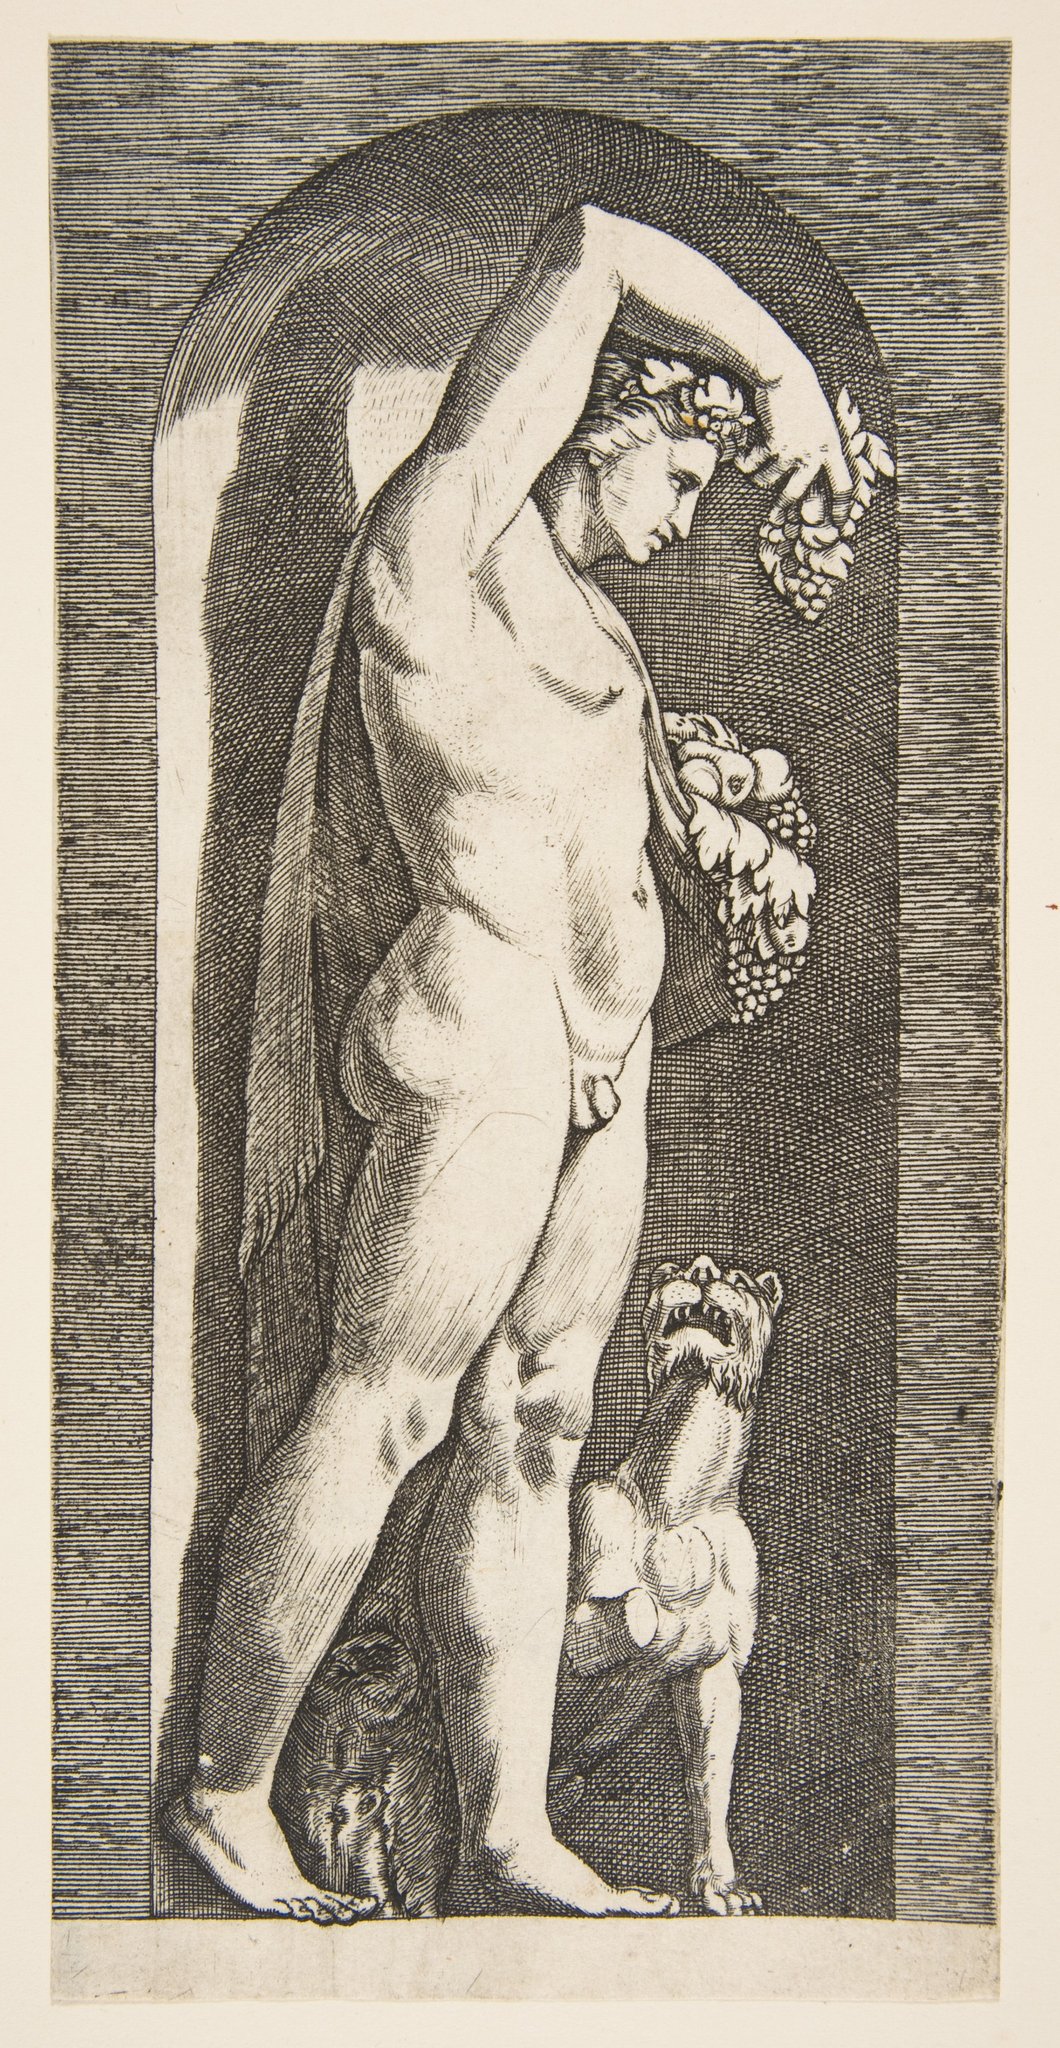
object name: print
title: Bacchus standing in a niche holding grapes in his raised right hand, fruit in his left hand, a dog lower right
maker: marco dente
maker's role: artist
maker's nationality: italian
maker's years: 1515-1527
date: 1515-1527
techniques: engraving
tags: grapes,male nudes,bacchus,dogs